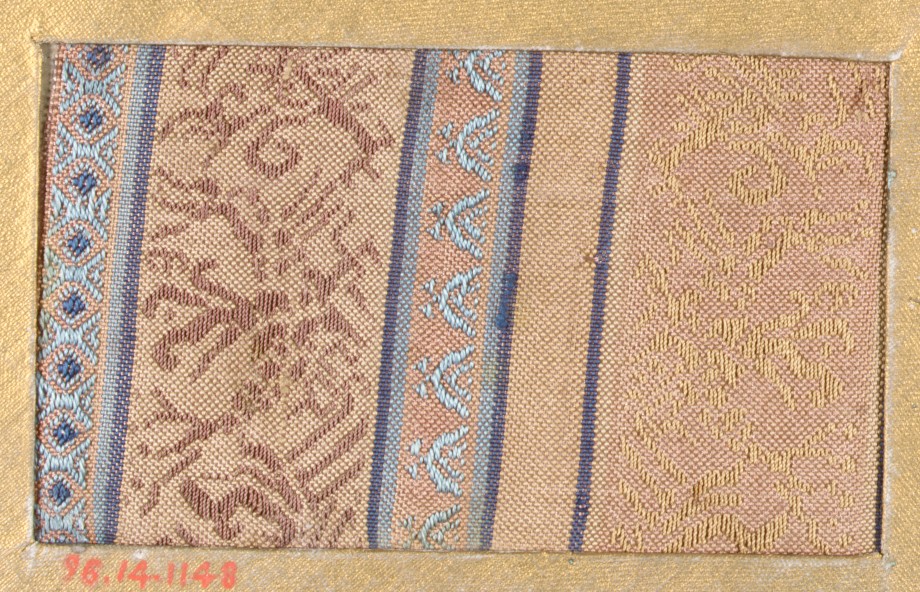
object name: piece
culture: japanese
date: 1701-1900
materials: silk